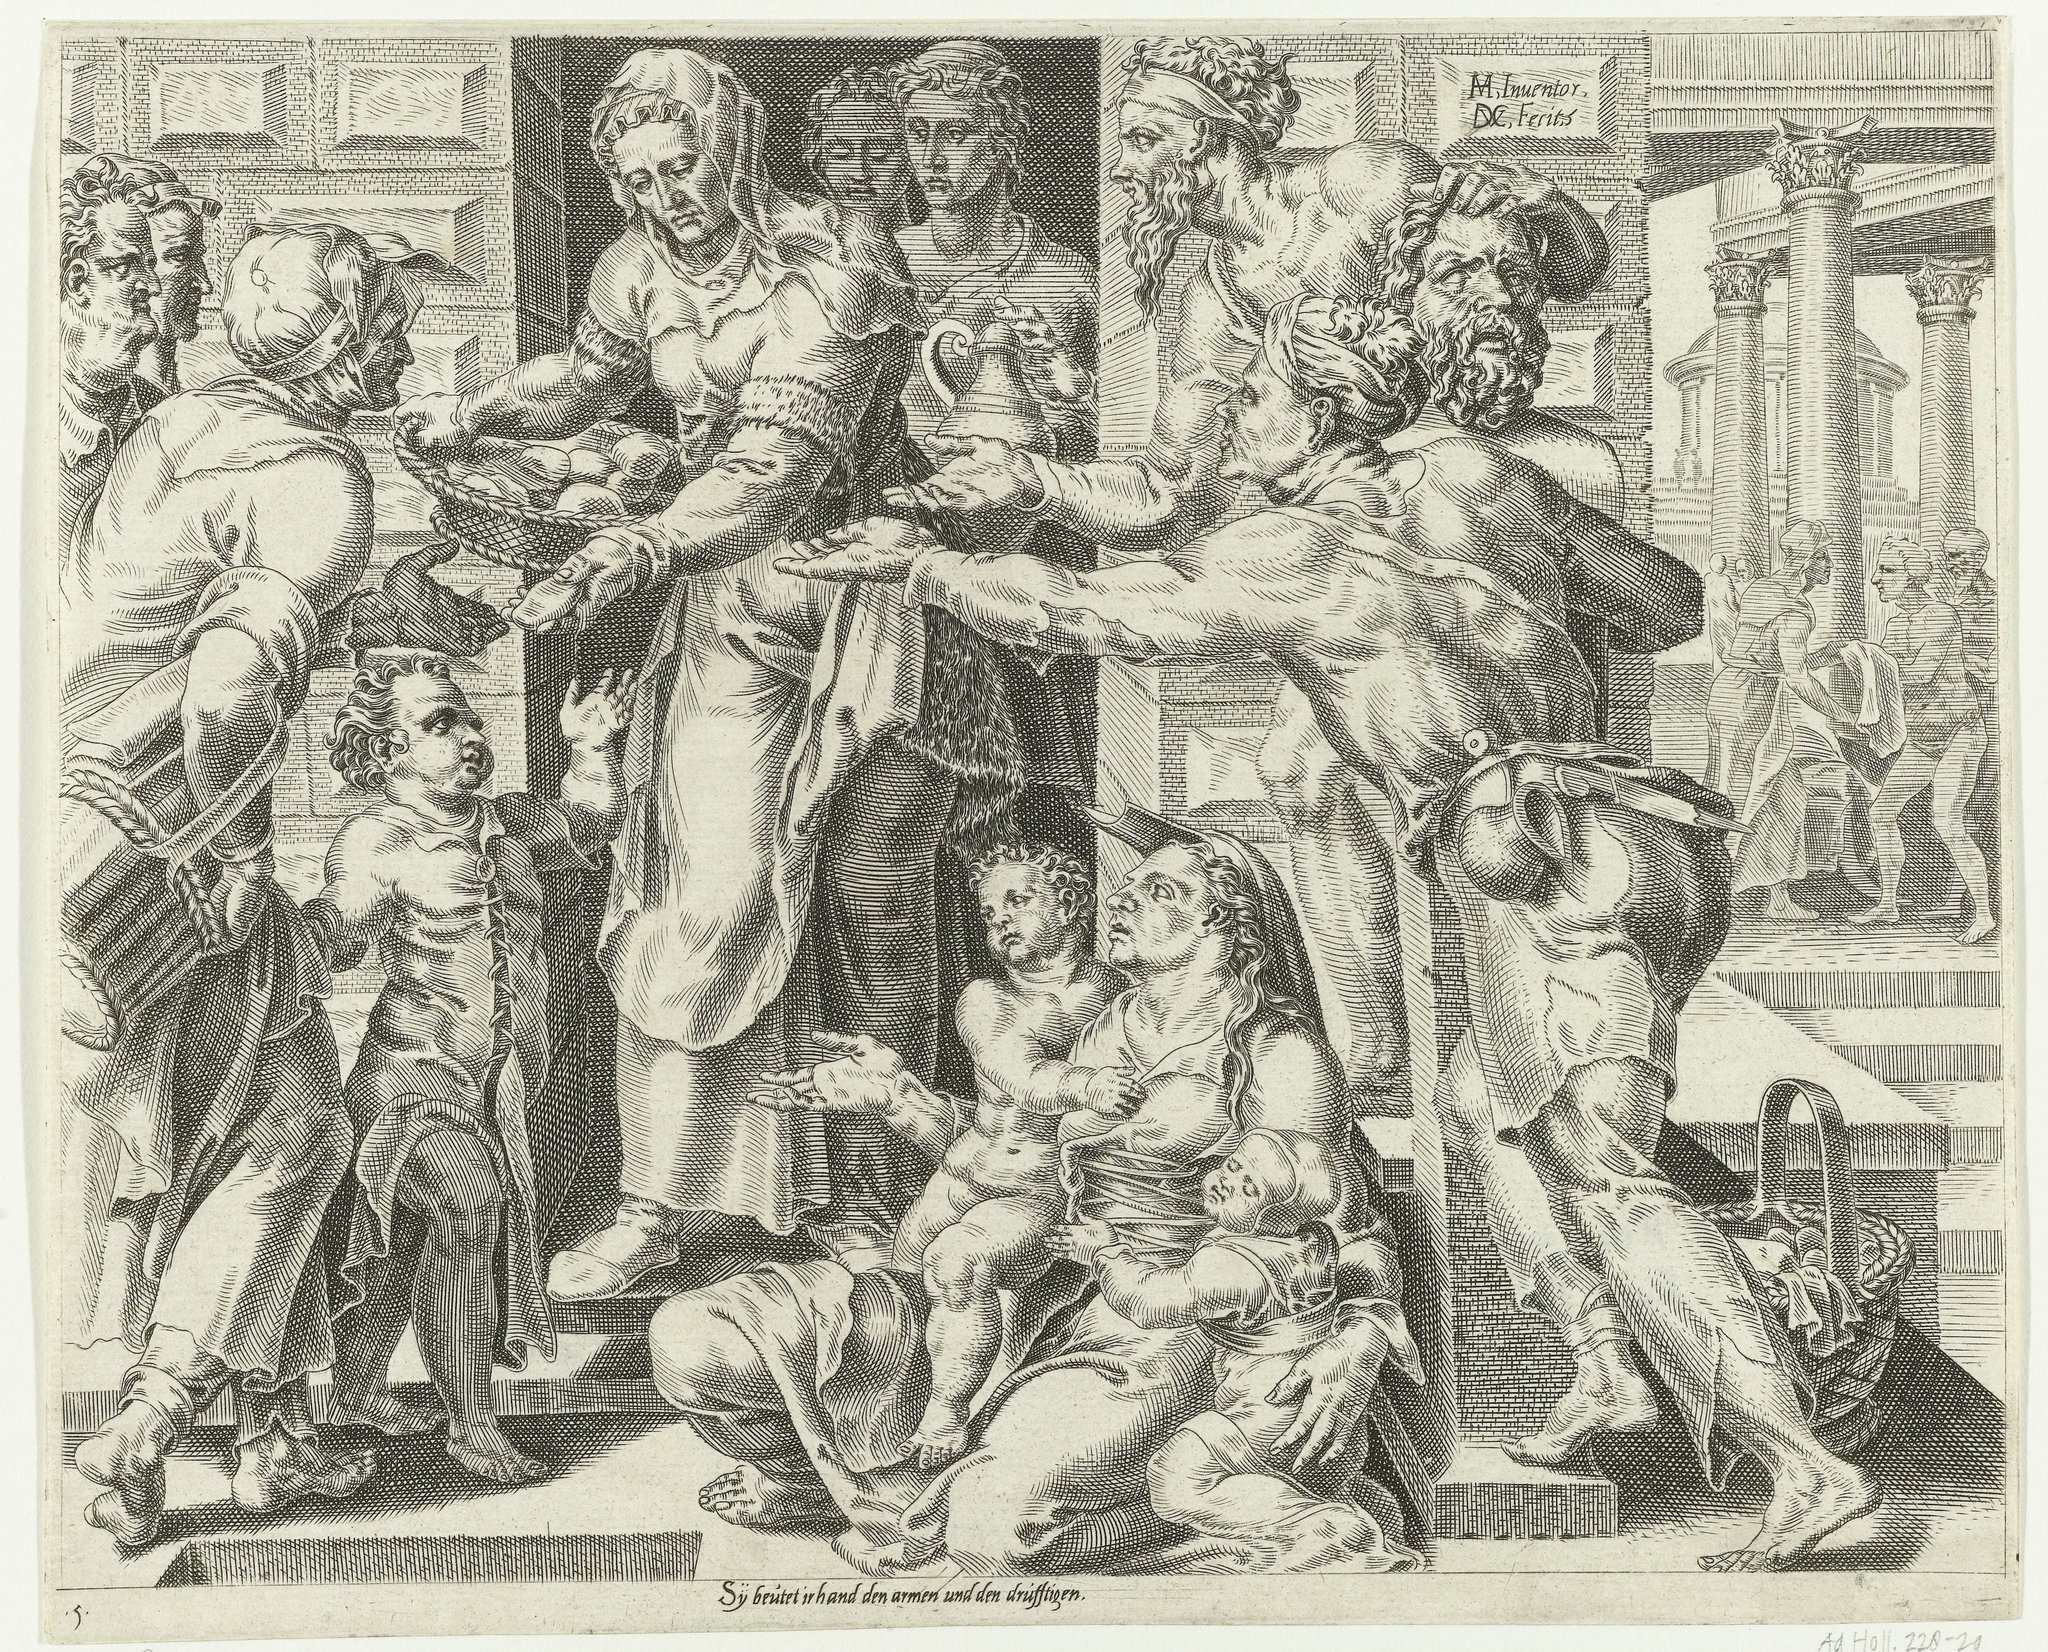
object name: print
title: Lof op de Deugdzame Huisvrouw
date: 1555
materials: paper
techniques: engraving, etching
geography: haarlem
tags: charity, 'caritas'; 'carità' (ripa) ~ one of the three theological virtues, the book of proverbs (with book chapter:verse), feeding the hungry, 'esuriens cibatur' ~ one of the (seven) acts of mercy, clothing the naked, 'nudus vestitur' ~ one of the (seven) acts of mercy, ideal wife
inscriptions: collector's mark: Lugt 2228, collector's mark: Lugt 2760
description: De deugdzame vrouw deelt brood uit aan de armen. Een van de bedelaars is de personificatie van Naastenliefde. Op de achtergrond kleedt de deugdzame vrouw de naakten. De prent is gebaseerd op Spreuken 31:20: 'Haar handen strekt zij uit naar de behoeftigen, ze geeft de armen hulp'. De afbeelding heeft een Duits onderschrift en maakt deel uit van een zesdelige prentserie die de bezigheden van de deugdzame huisvrouw looft.